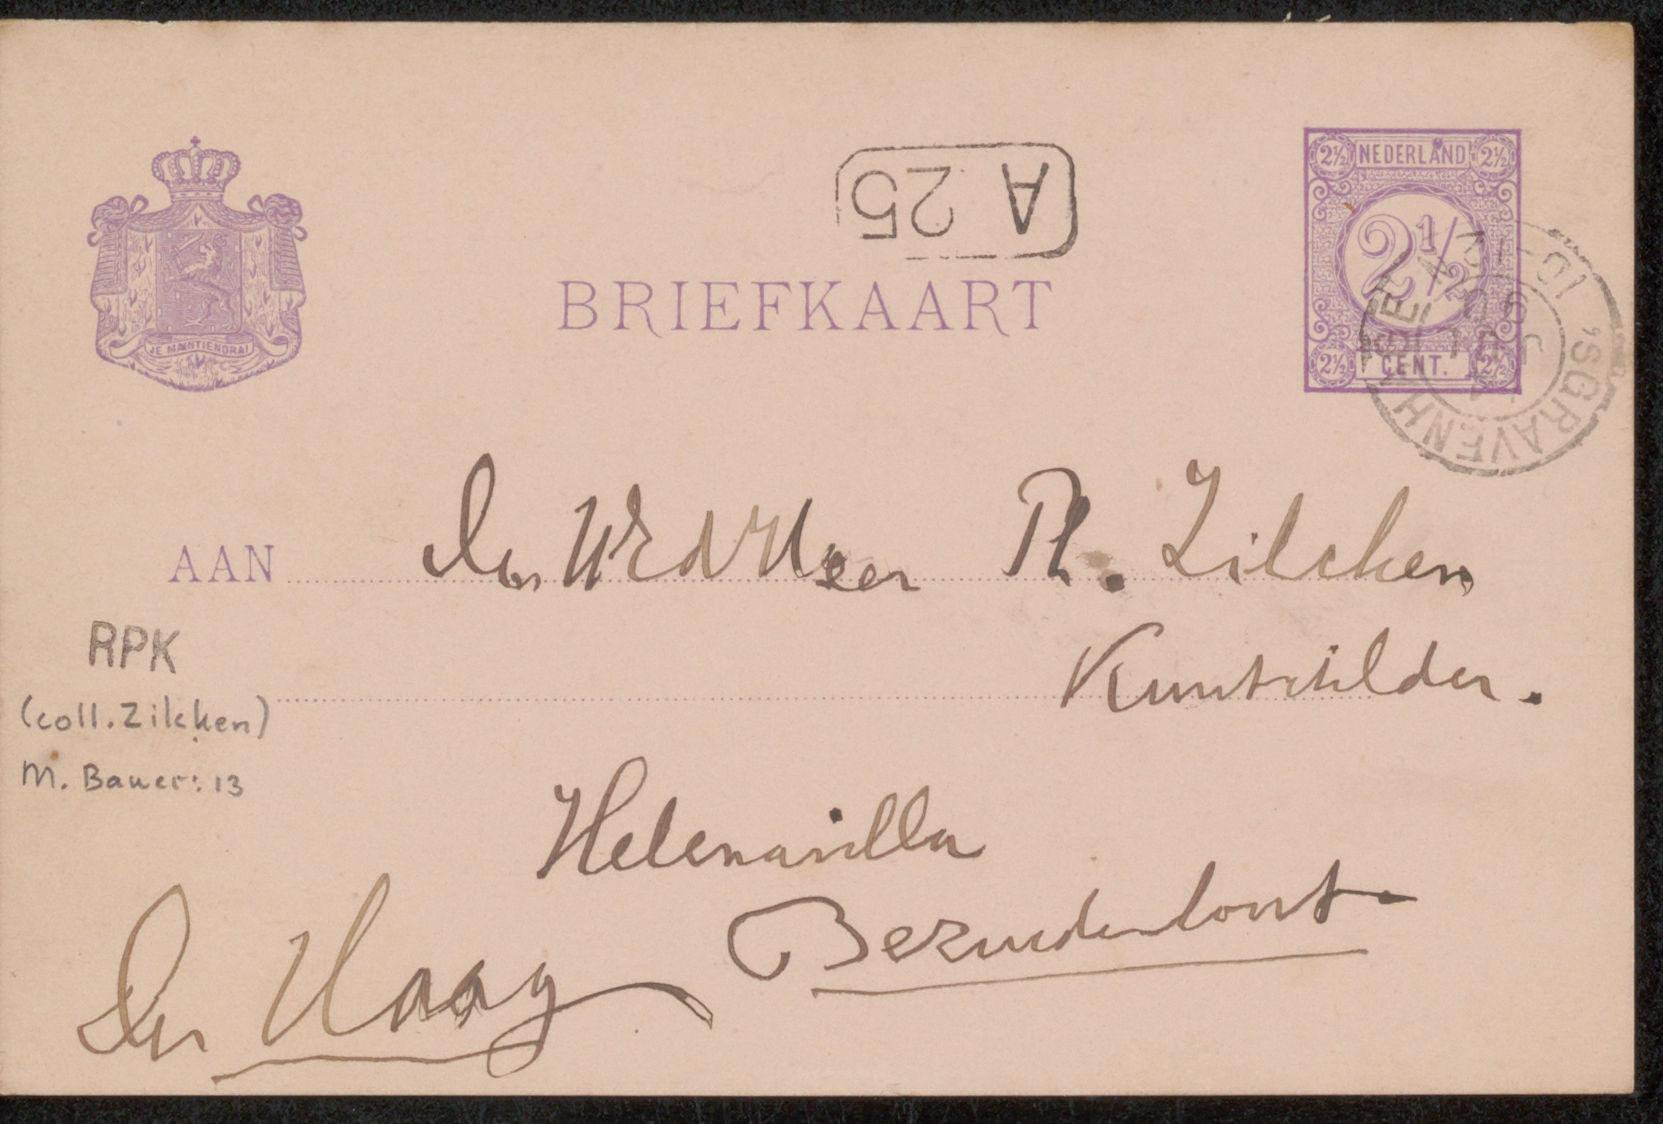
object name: postcard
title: Briefkaart aan Philip Zilcken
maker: marius bauer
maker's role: draughtsman, print maker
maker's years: 1867-1932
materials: cardboard, ink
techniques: pen, writing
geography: the hague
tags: painter, draughtsman, philip zilcken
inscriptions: collector's mark: ‘RPK’